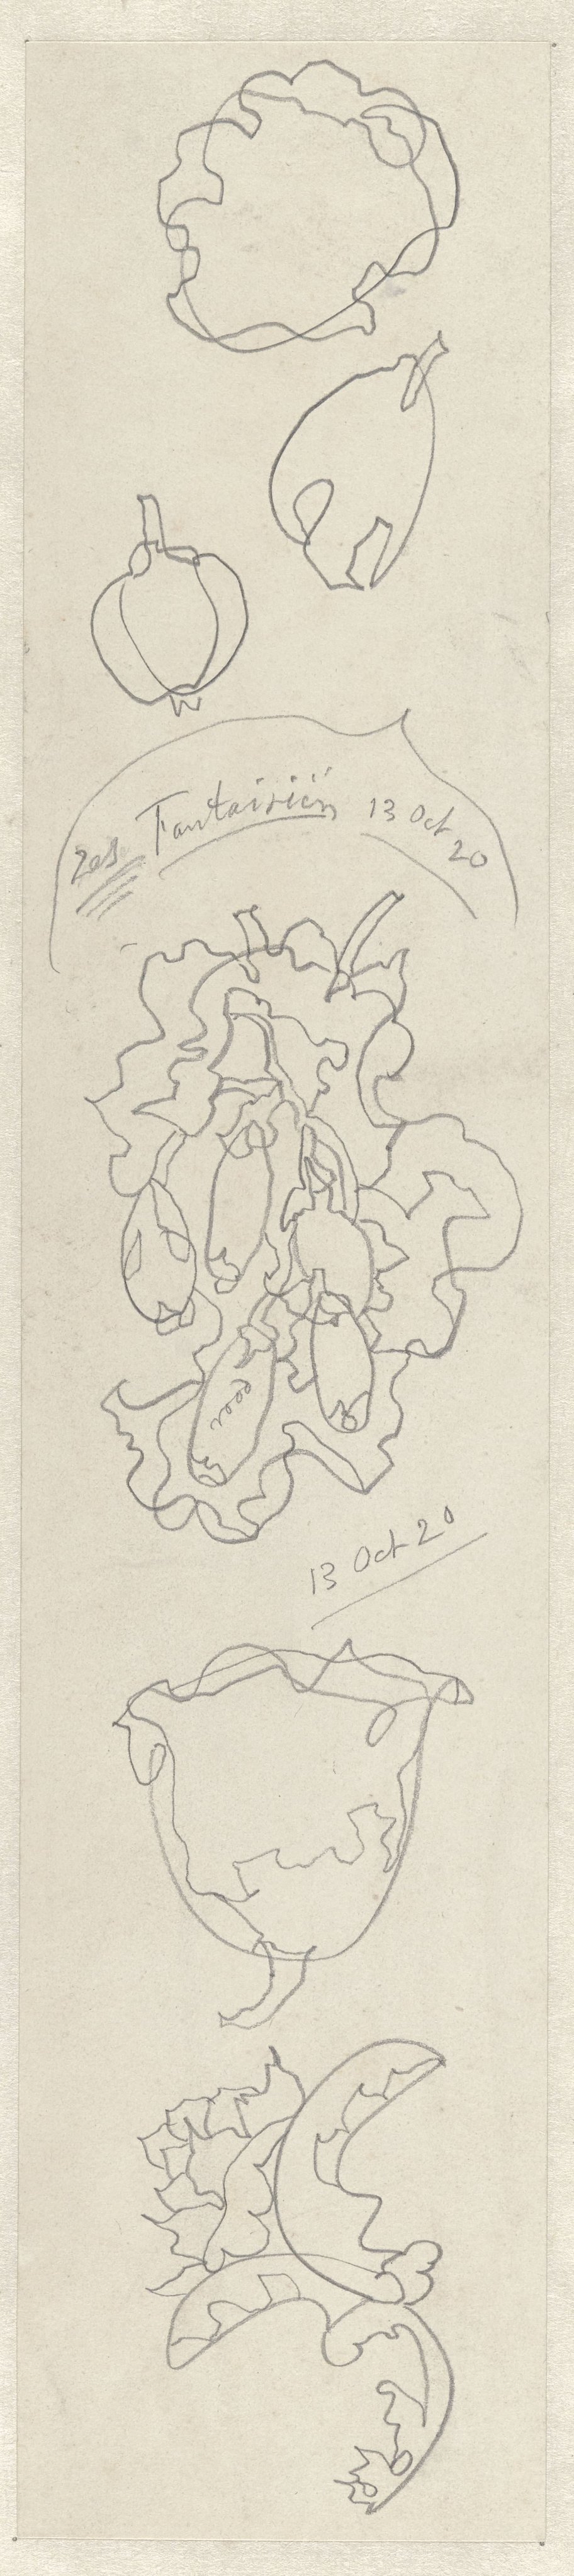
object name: drawing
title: Ontwerpen met plantaardige motieven voor aardewerkdecoratie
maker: theo colenbrander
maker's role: draughtsman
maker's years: 1841-1930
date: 1920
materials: paper, pencil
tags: flowers ~ ornament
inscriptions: date: ‘13 oct 20’